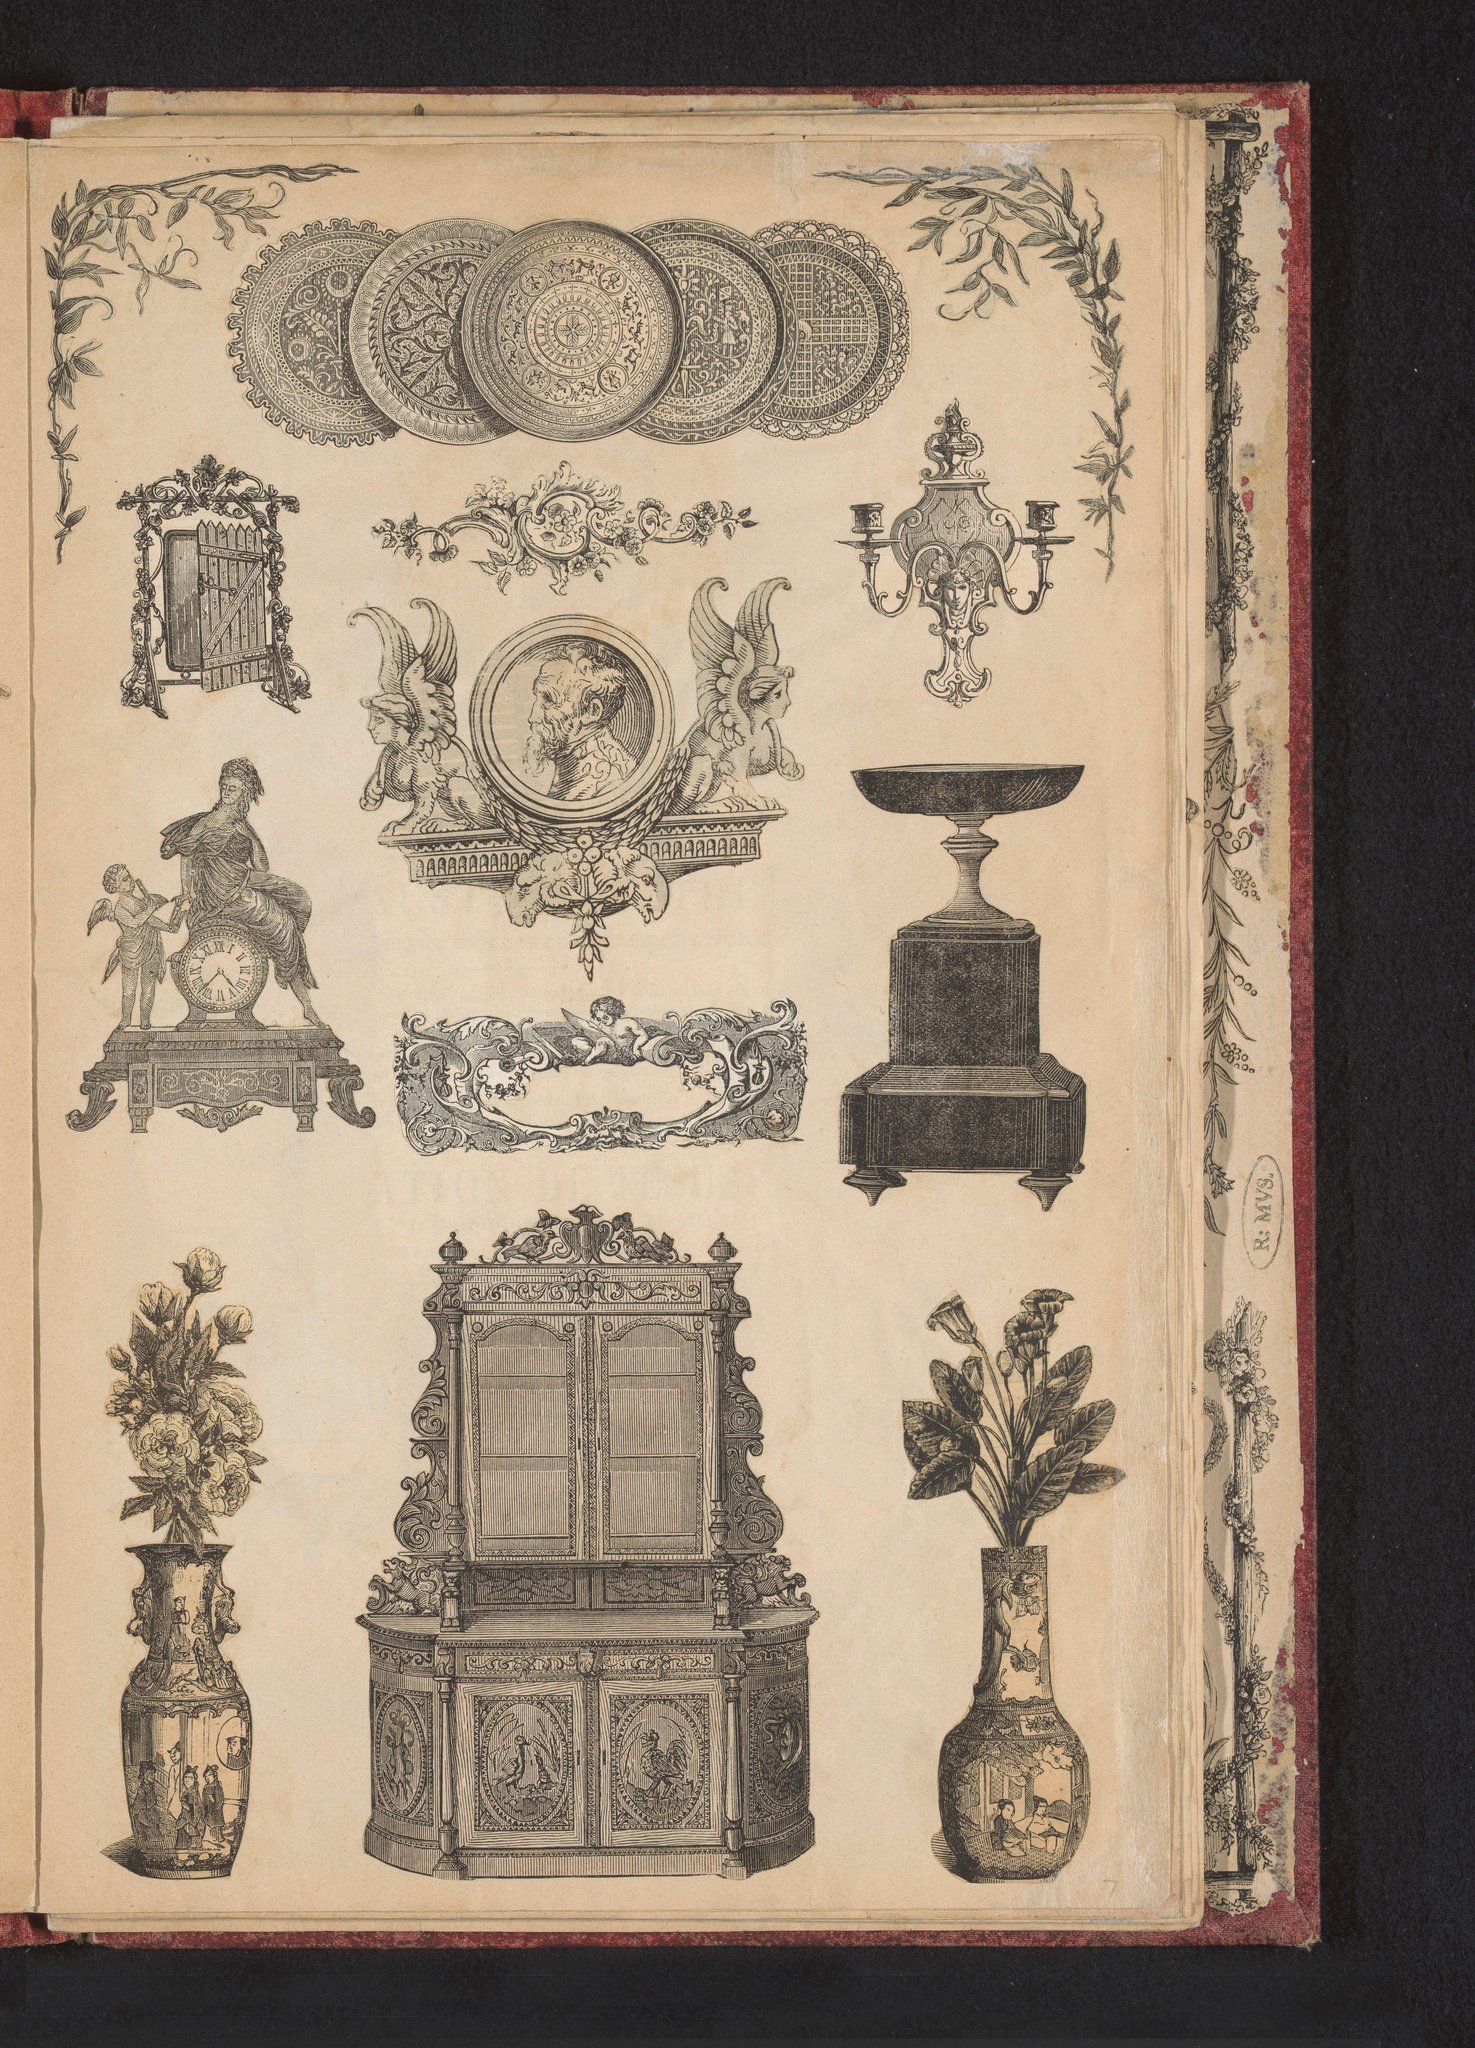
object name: print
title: Collage van uitgeknipte prenten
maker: Anonymous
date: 1870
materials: paper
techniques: engraving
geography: paris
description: Collage van uitgeknipte prenten. Onderdeel van een album met 32 bladen, aan beide zijden beplakt met uitgeknipte prenten, vermoedelijk afkomstig uit 19e-eeuwse tijdschiften.